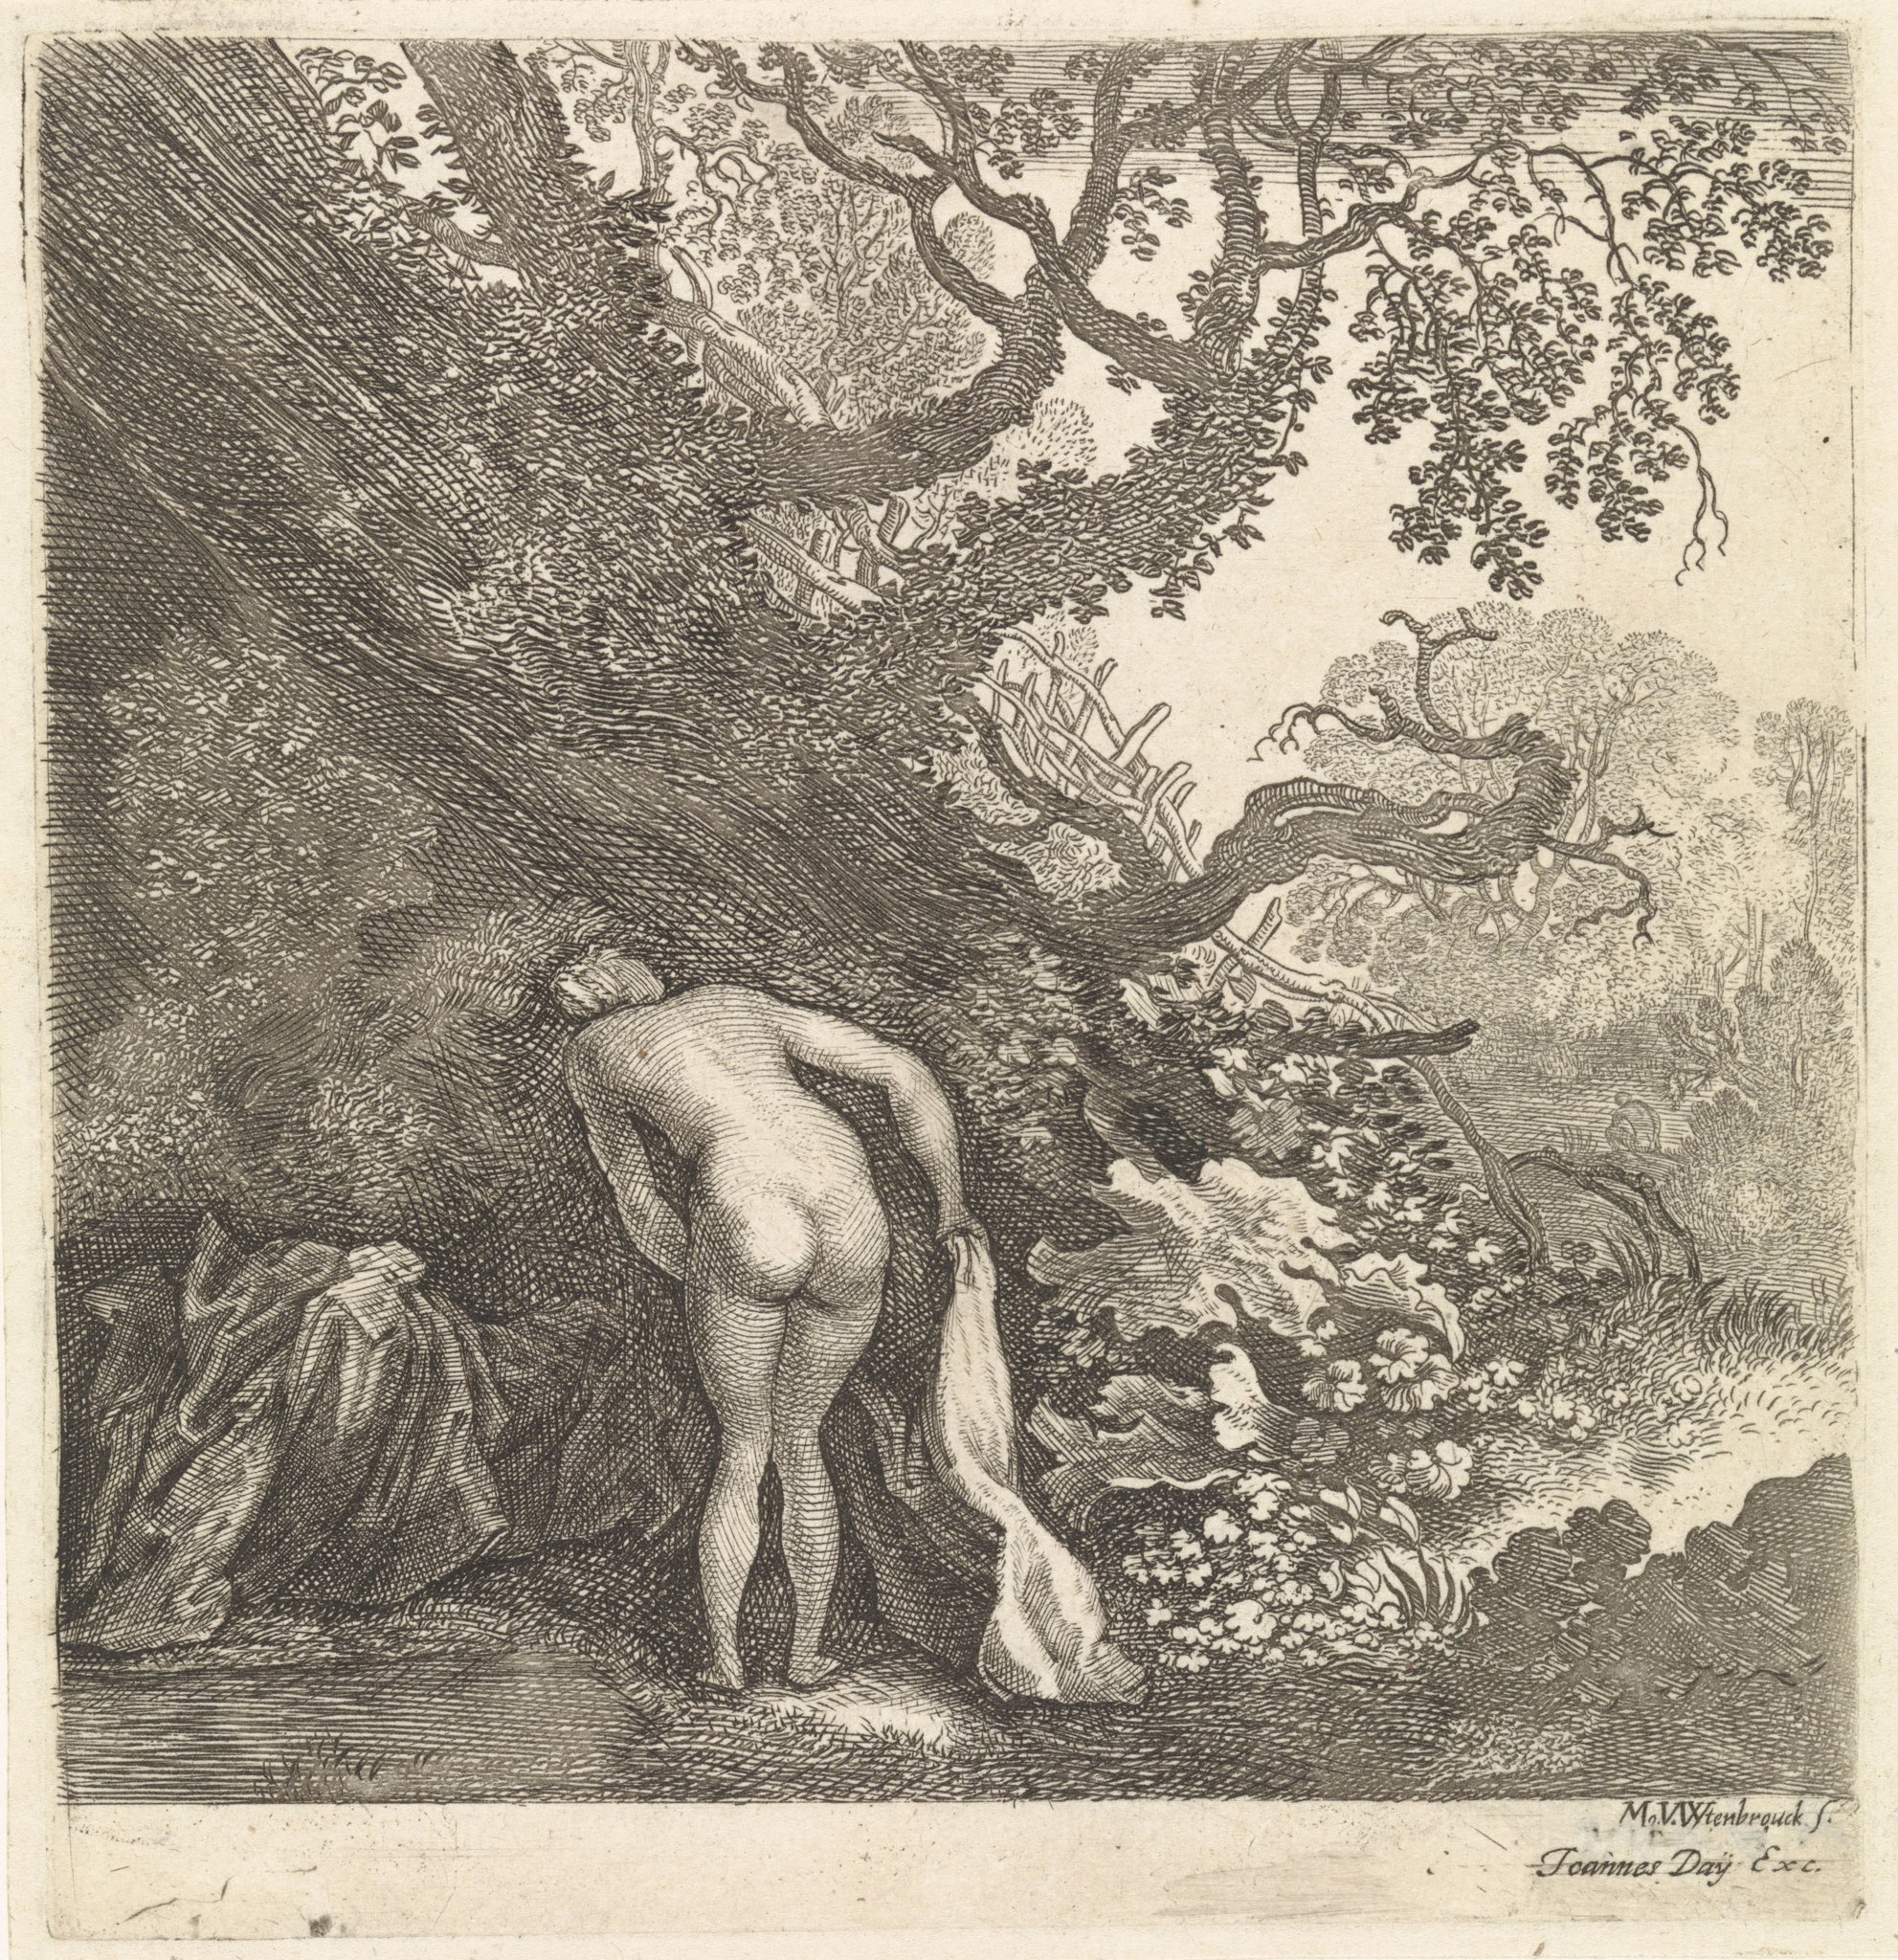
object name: print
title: Badende vrouw, van achteren gezien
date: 1600-1647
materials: paper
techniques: engraving, etching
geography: amsterdam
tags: 'après le bain' - aa - in the open air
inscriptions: collector's mark: Lugt 2228, collector's mark: Lugt 2610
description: Een naakte vrouw, aan de rand van een bosmeertje, buigt zich over haar op de grond liggende kleding.